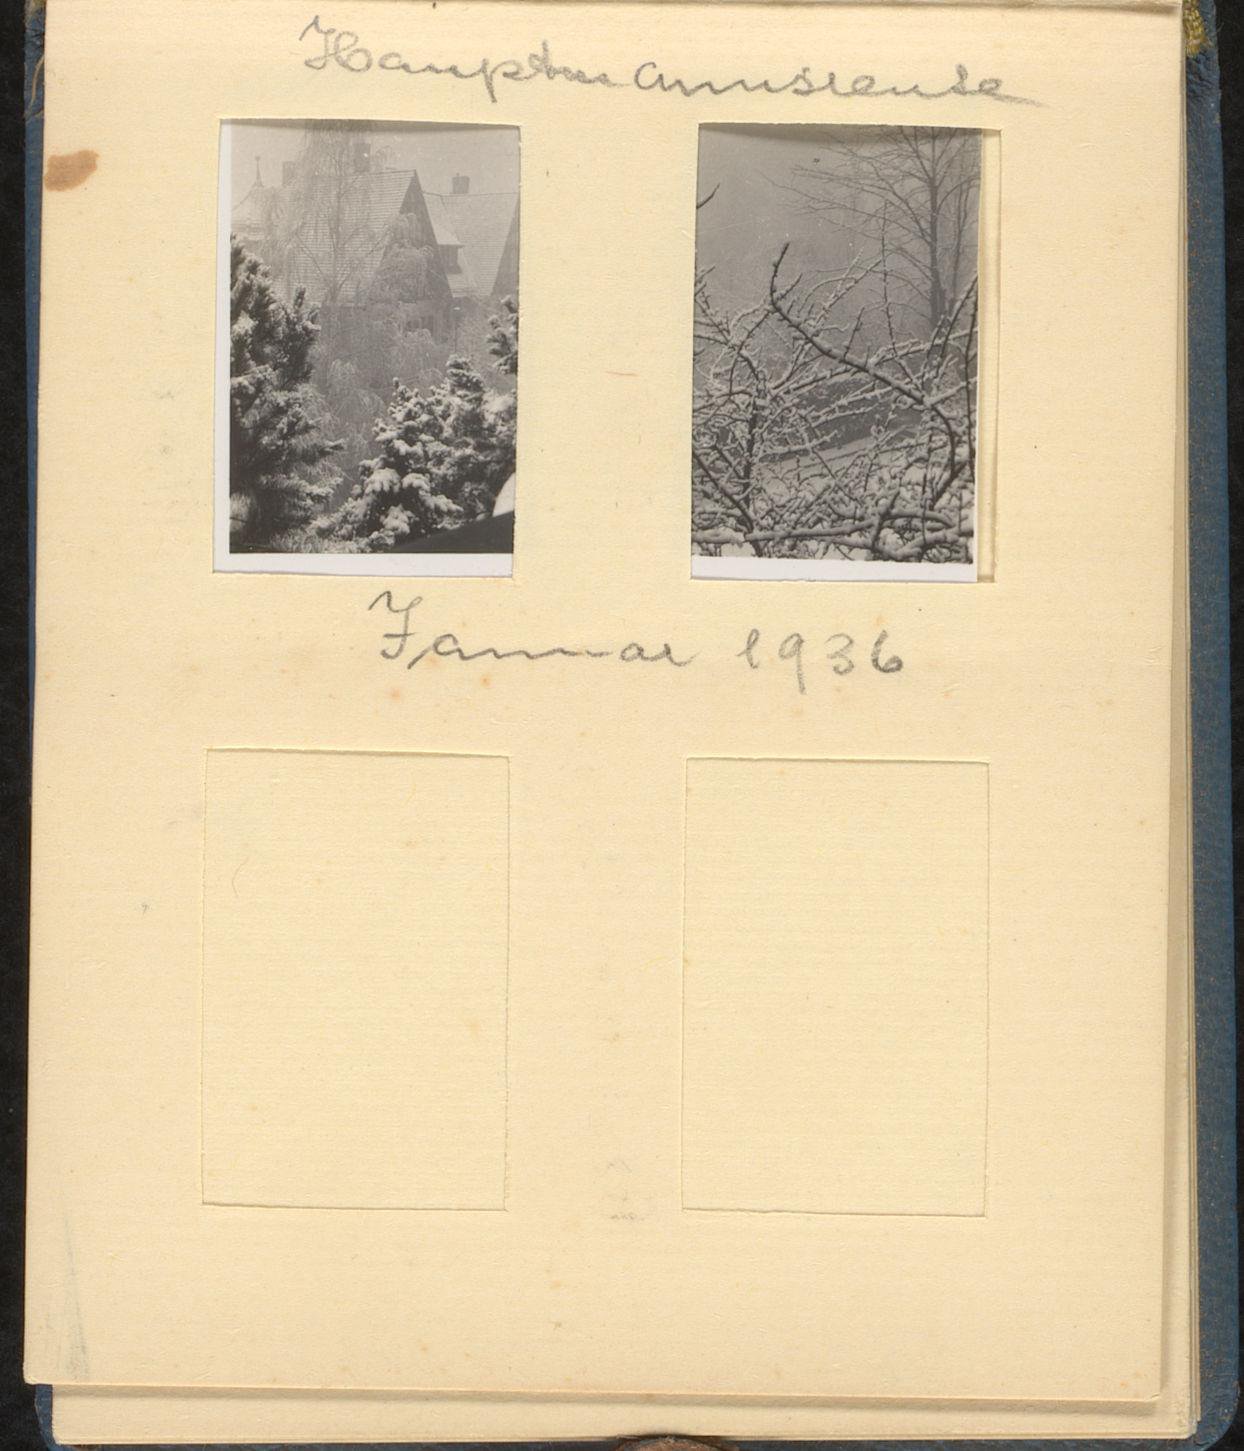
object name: photograph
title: Blik op een huis in de besneeuwde straat de Hauptmannsreute, januari 1936, Stuttgart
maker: else wachenheimer-moos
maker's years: 1895-1944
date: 1901-1936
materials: paper, photographic support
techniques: gelatin silver print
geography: stuttgart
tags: snow, public road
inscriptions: inscription: ‘Hauptmannsreute Januar 1936’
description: Albumblad bevat twee foto's. Zonder personen gerelateerd aan de familie Wachenheimer. Uit klein formaat fotoalbum, blauw lederen omslag met drukknopsluiting. Met foto's in klein formaat.